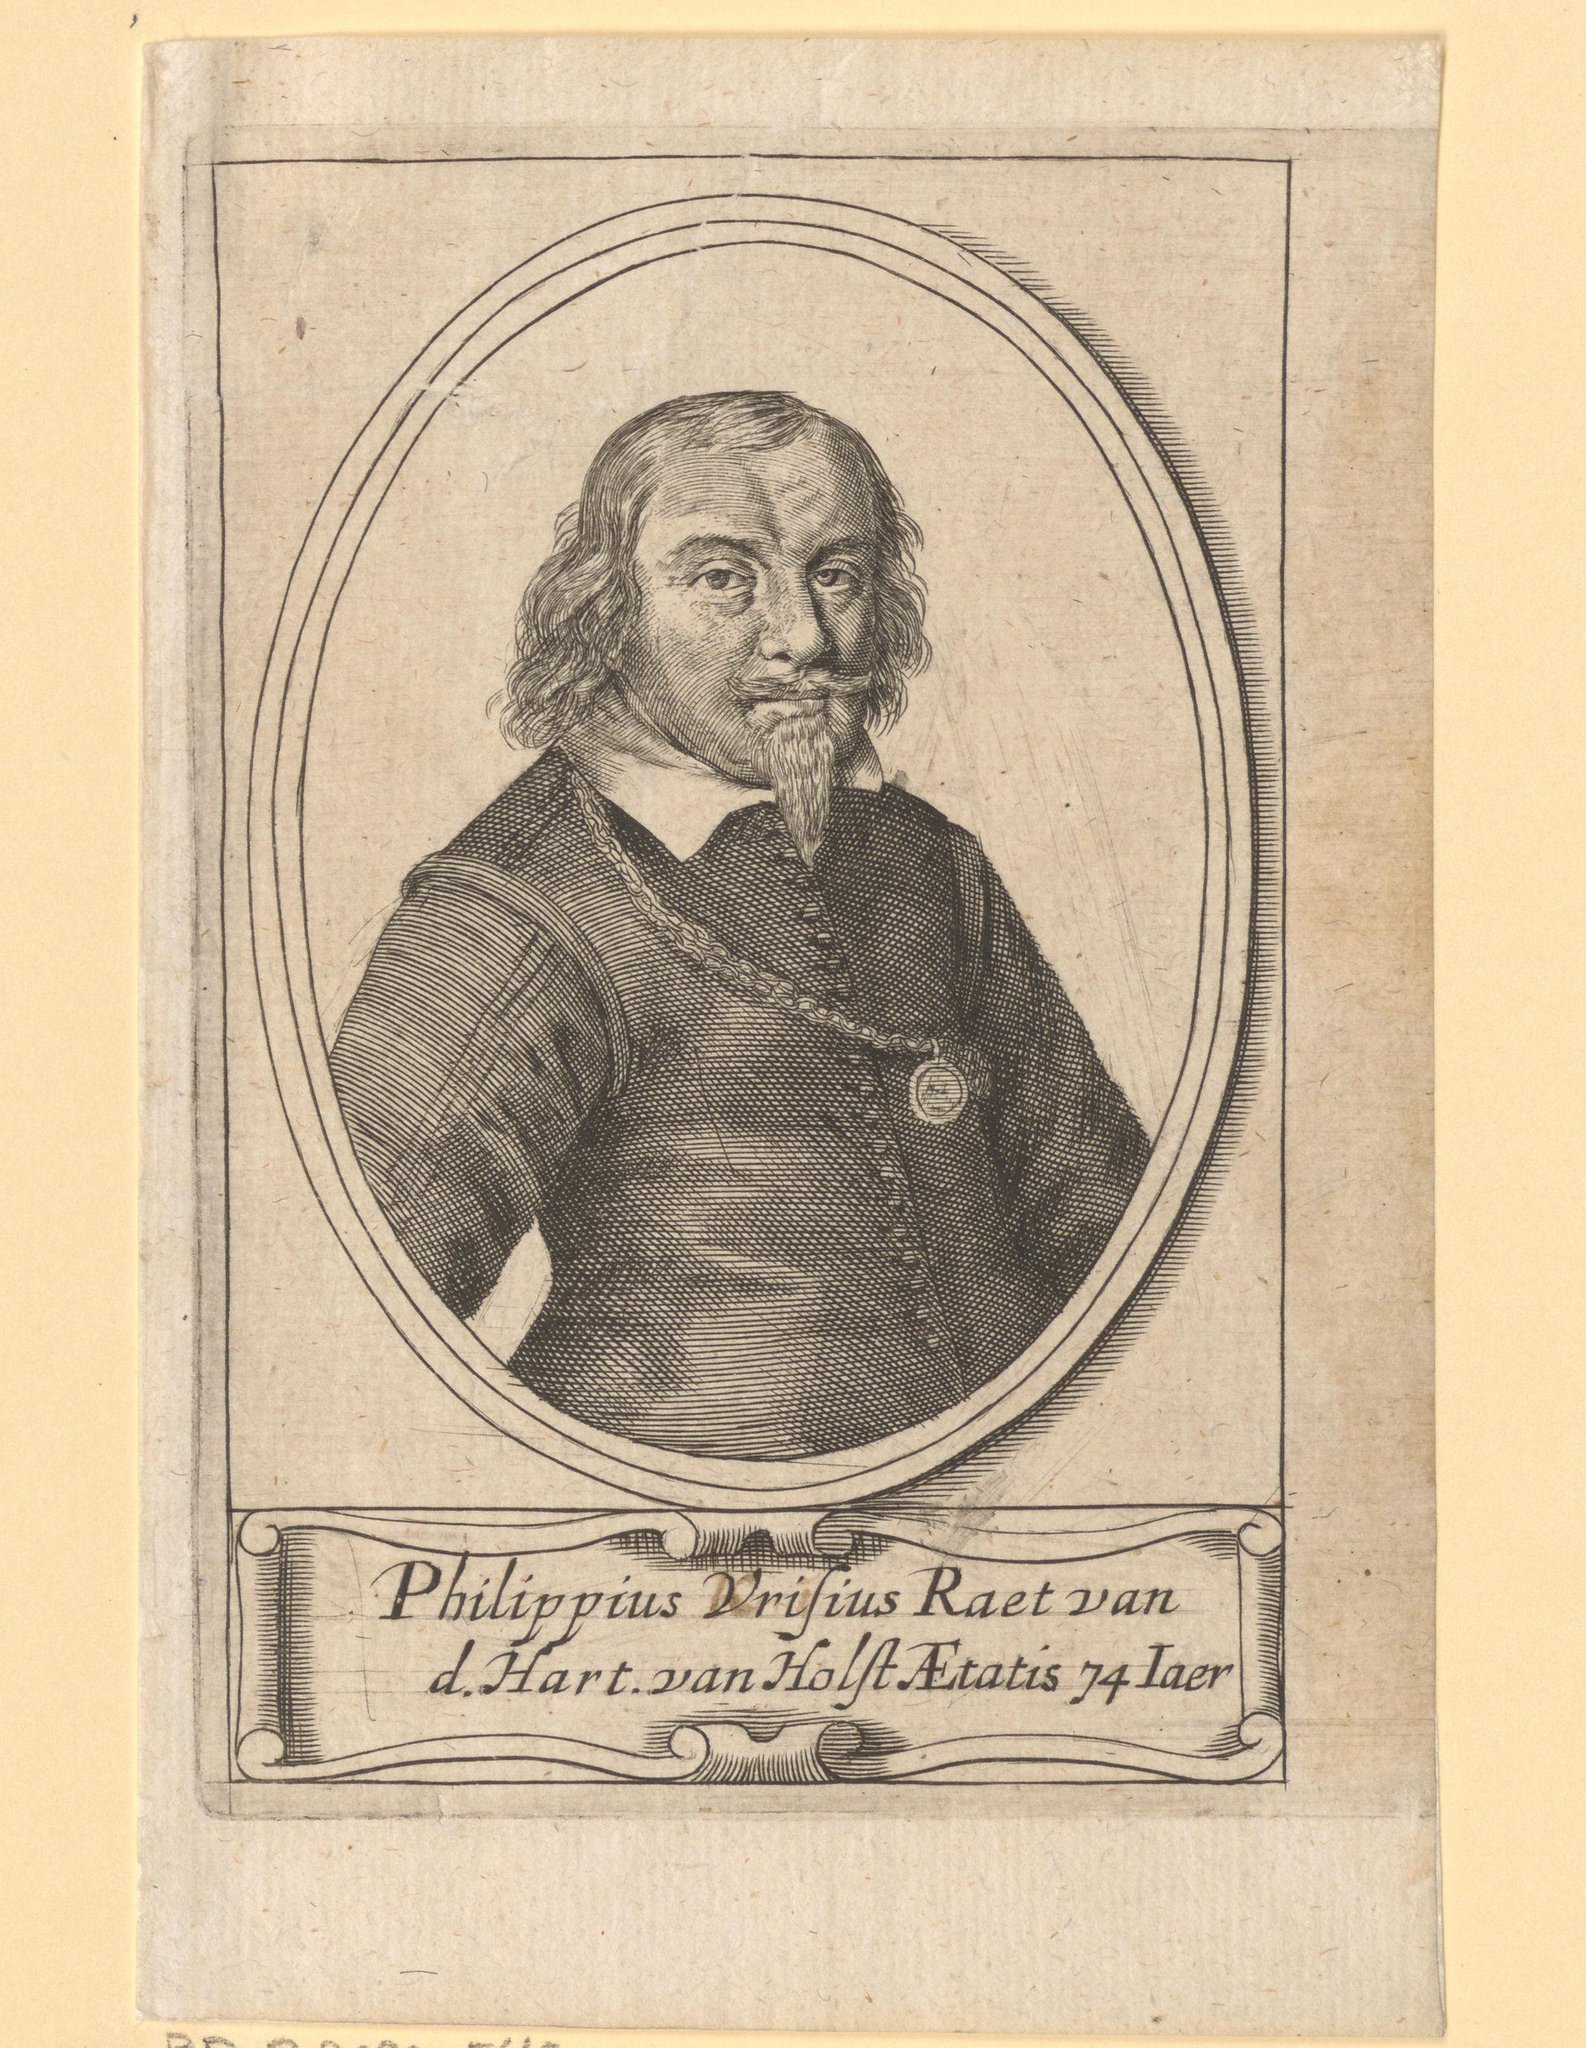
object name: print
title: Portret van Philipp Crusius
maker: Anonymous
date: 1651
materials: paper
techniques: engraving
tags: politician, historical persons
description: Prent mogelijk uit: Olearius, Adam. Beschrijvingh vande nieuwe Parciaensche, ofte orientaelsche reyse (...). Amsterdam: Jacob Benjamin, 1651.